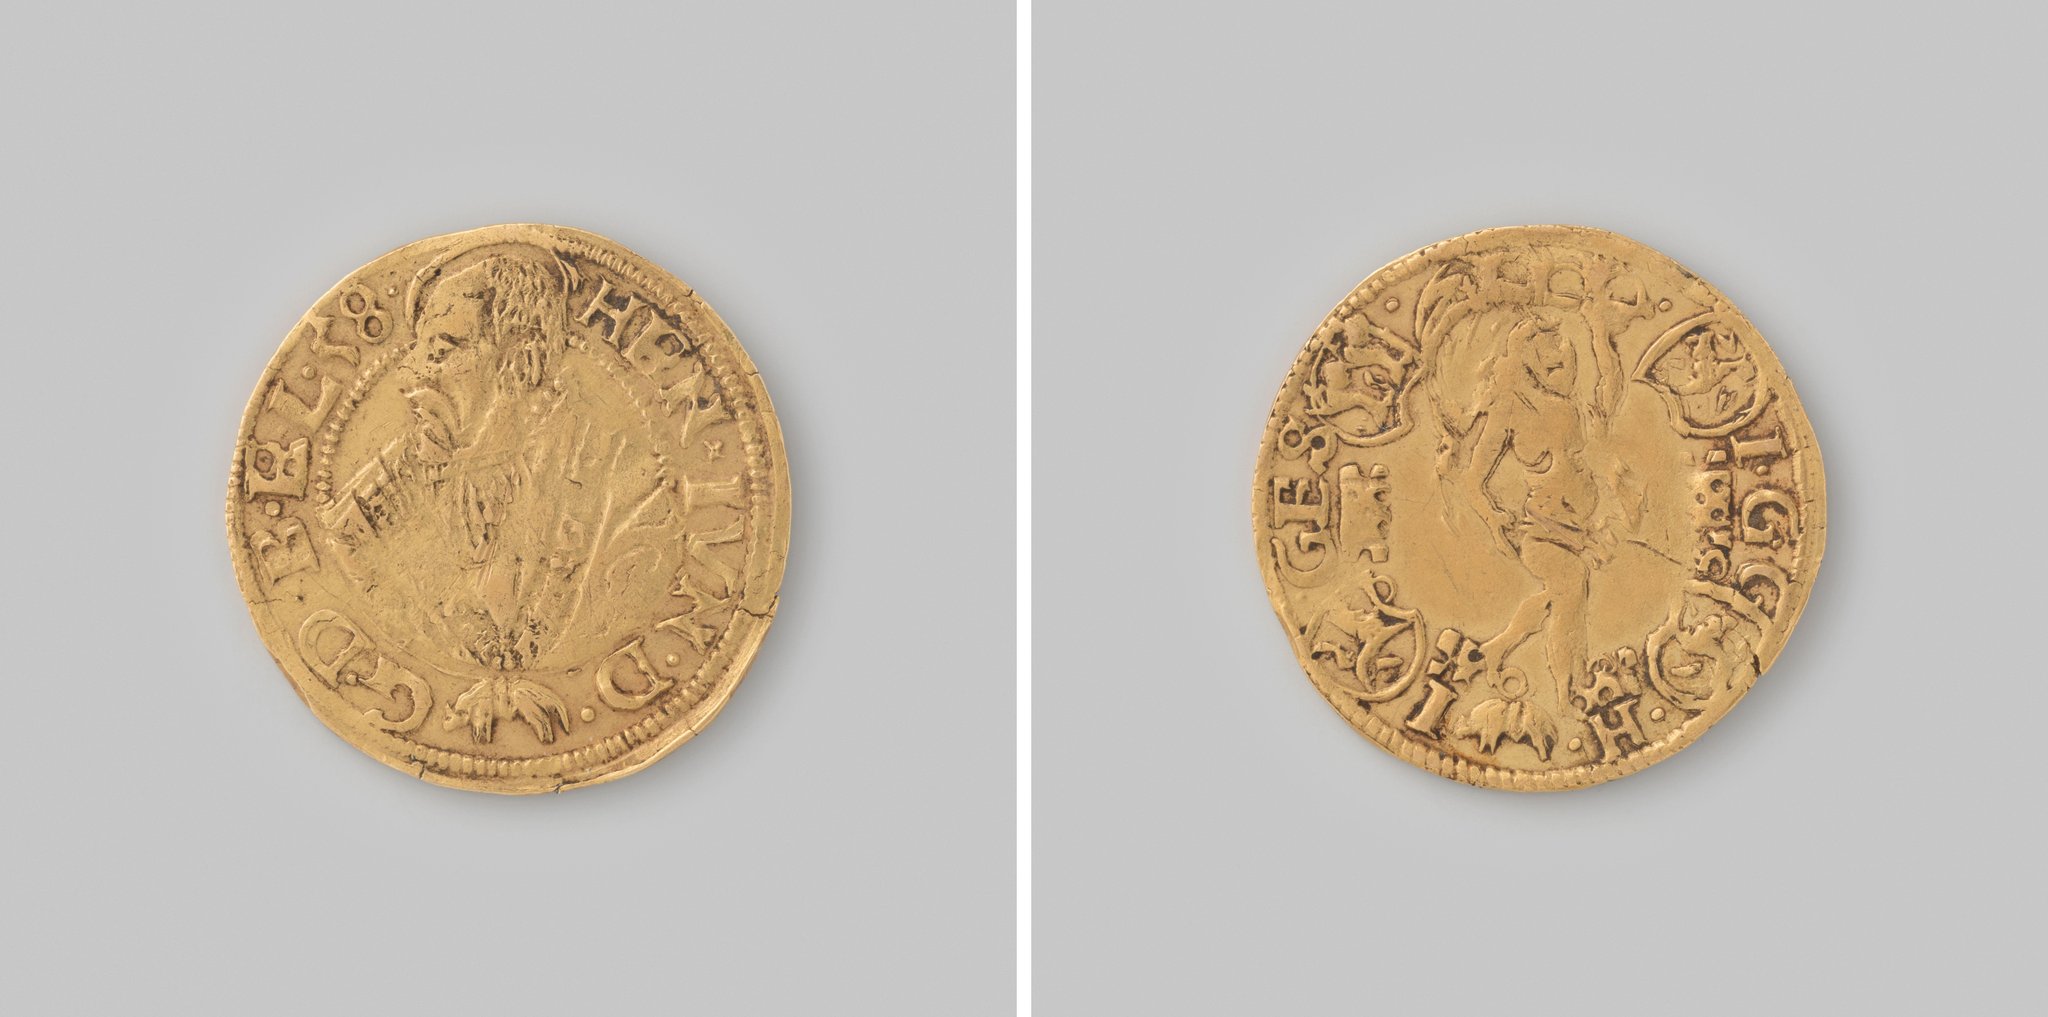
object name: coin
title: Dukaat uit Brunswijk van Heinrich II, 1558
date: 1558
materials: gold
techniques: striking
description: Gouden munt. Voorzijde: borstbeeld van de vorst met keten en juweel van het Gulden Vlies naar links. Jaartal: 58 in omschrift. Keerzijde: binnen vier wapenschilden en de keten met juweel van de Orde van het Gulden Vlies staande Fortuna naar rechts.